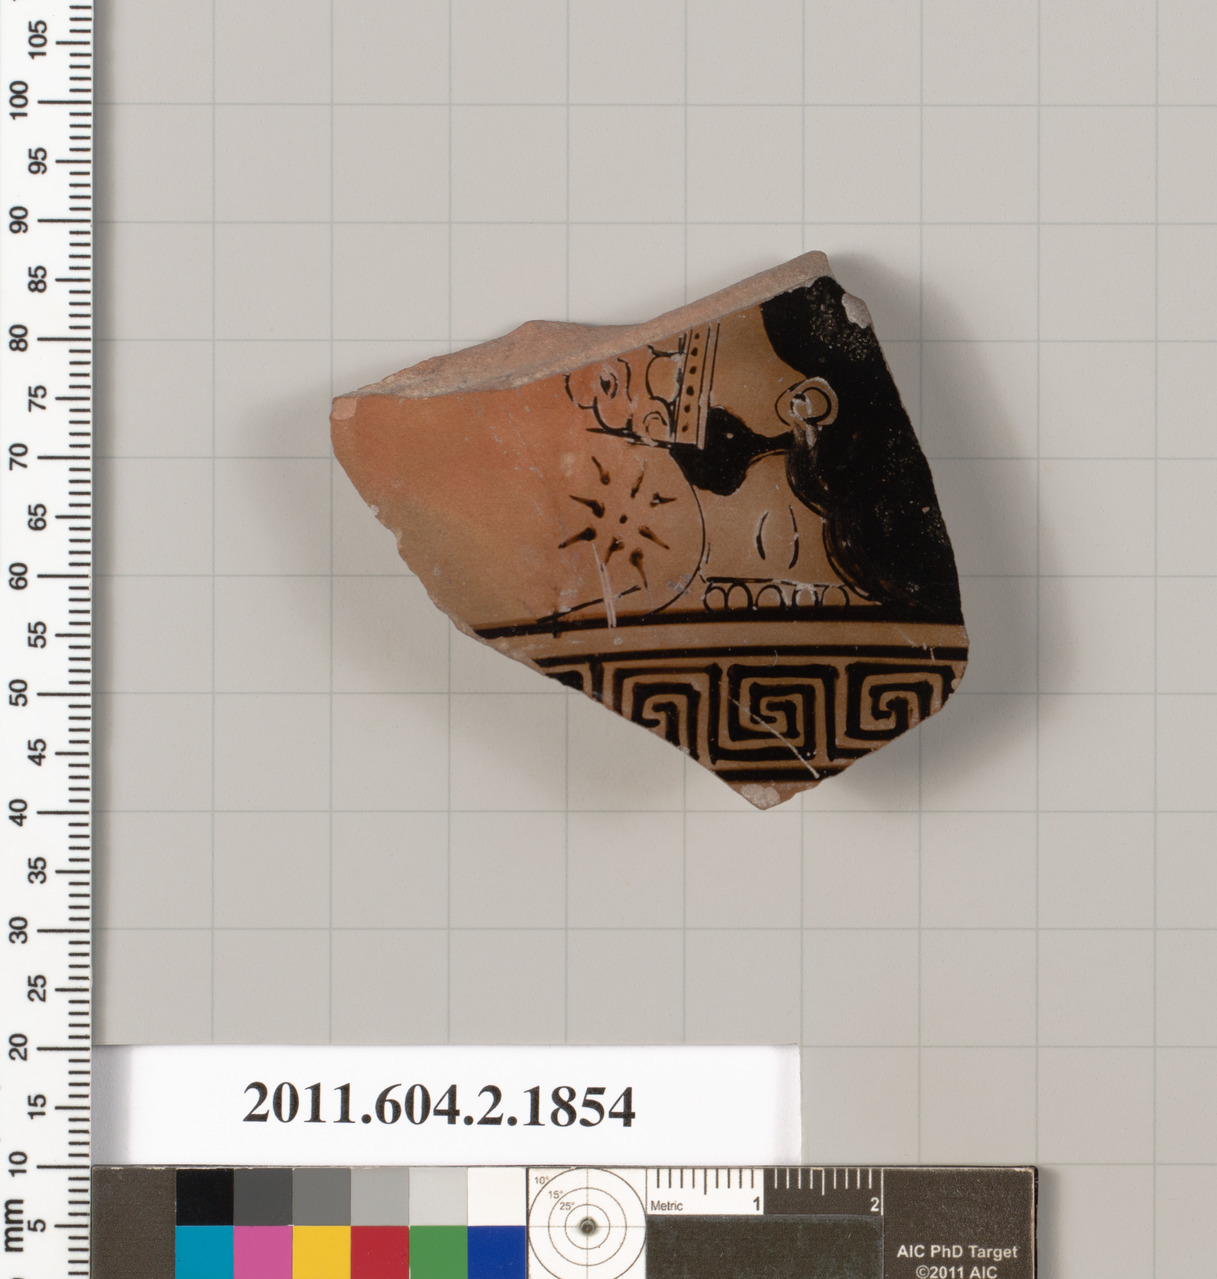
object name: skyphos fragment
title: Terracotta fragment of a skyphos (deep drinking cup)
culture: greek, attic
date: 490-470 BCE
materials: terracotta